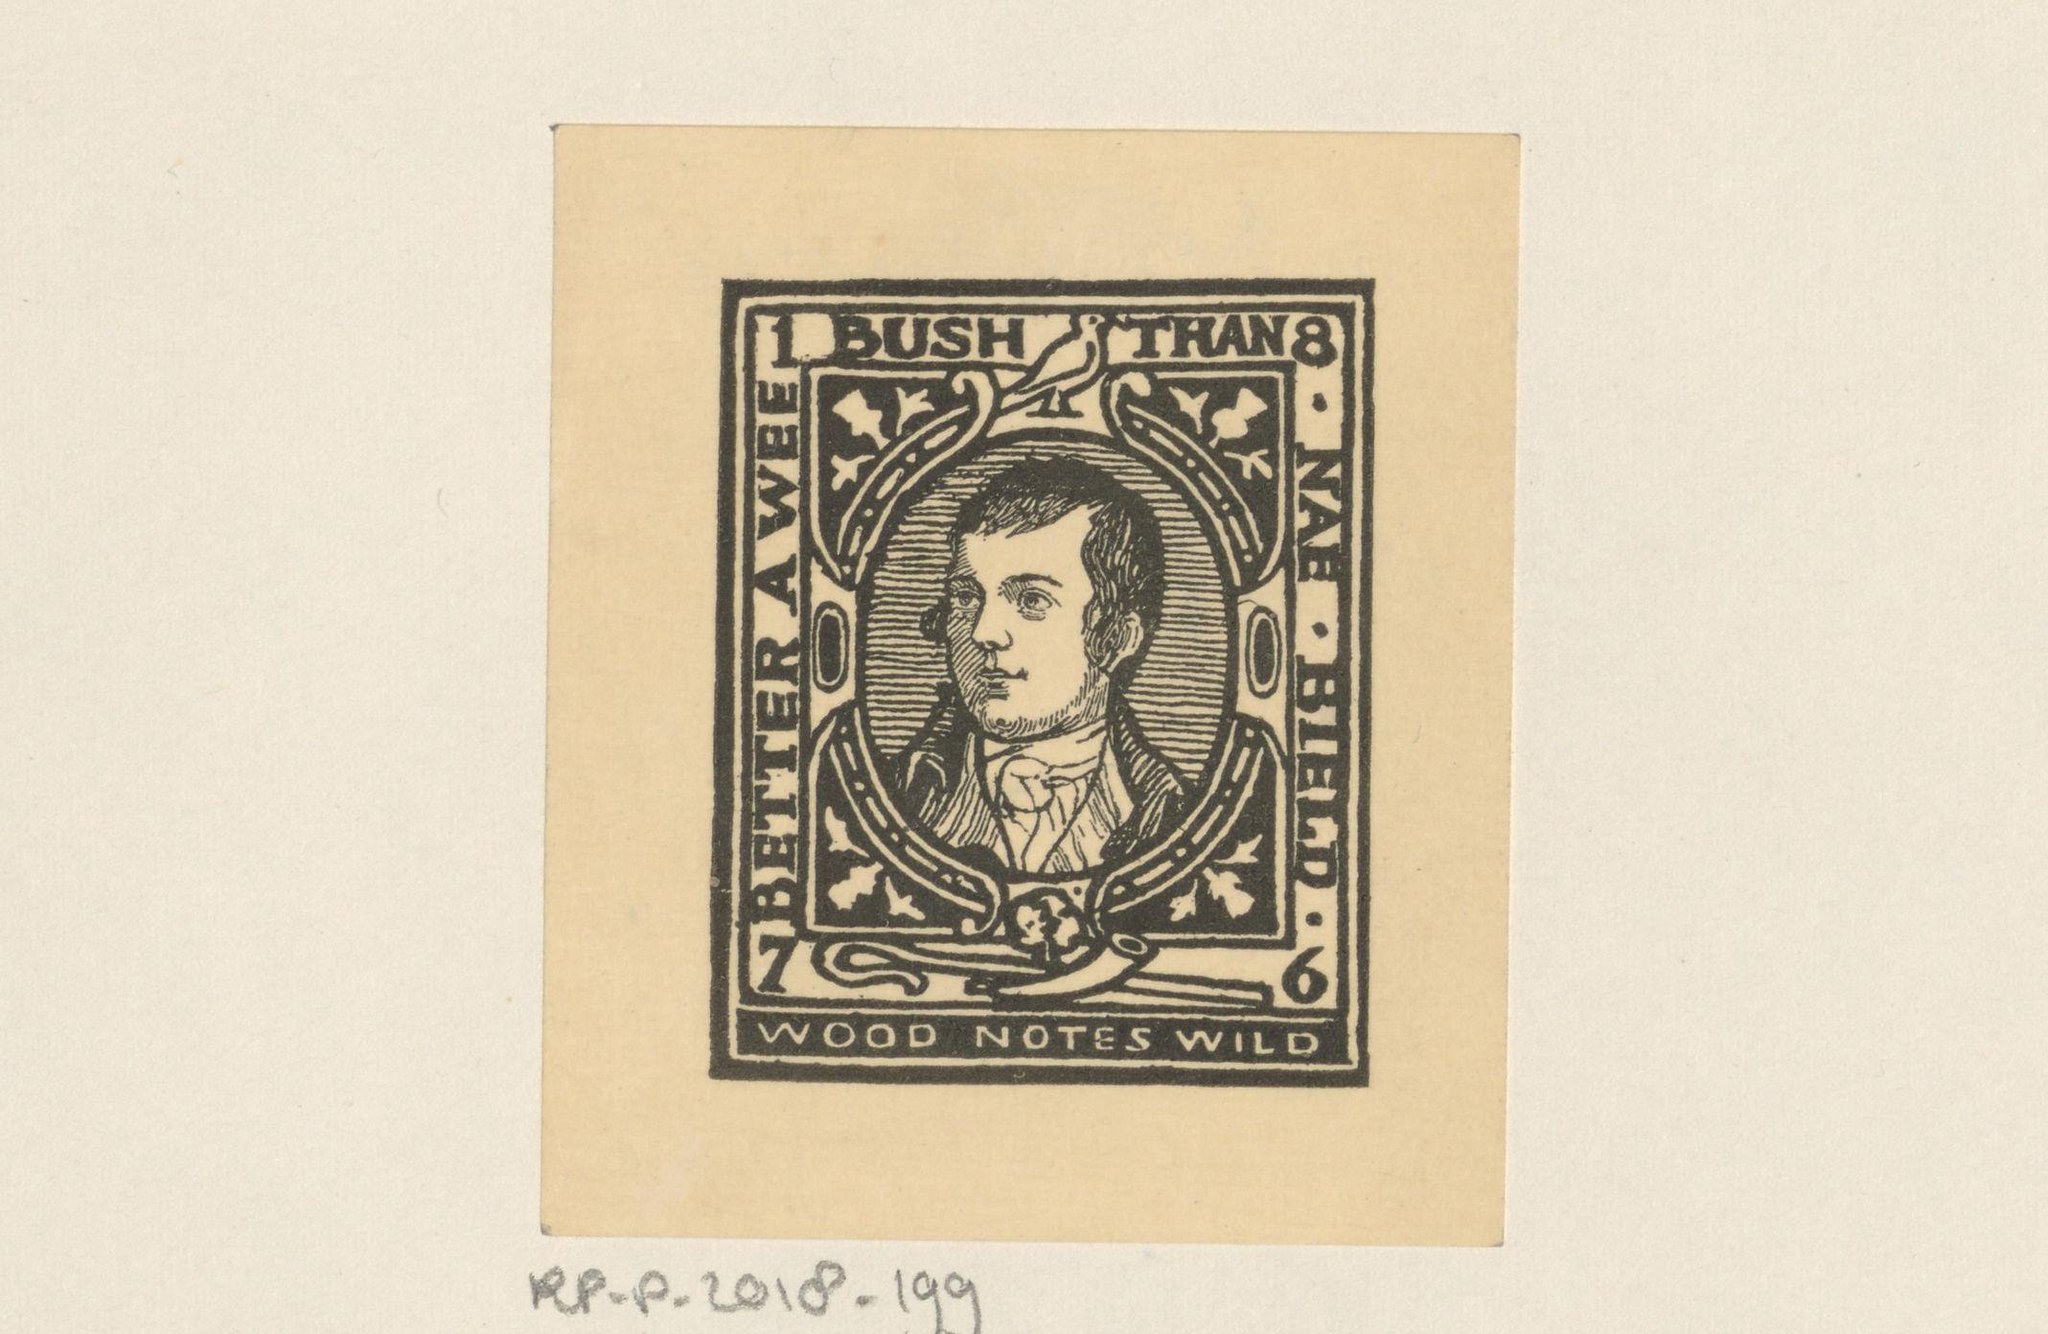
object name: bookplate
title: Better a wee bush than nae bield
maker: Anonymous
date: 1876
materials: paper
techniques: relief print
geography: england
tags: head (human), birds, historical persons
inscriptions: date